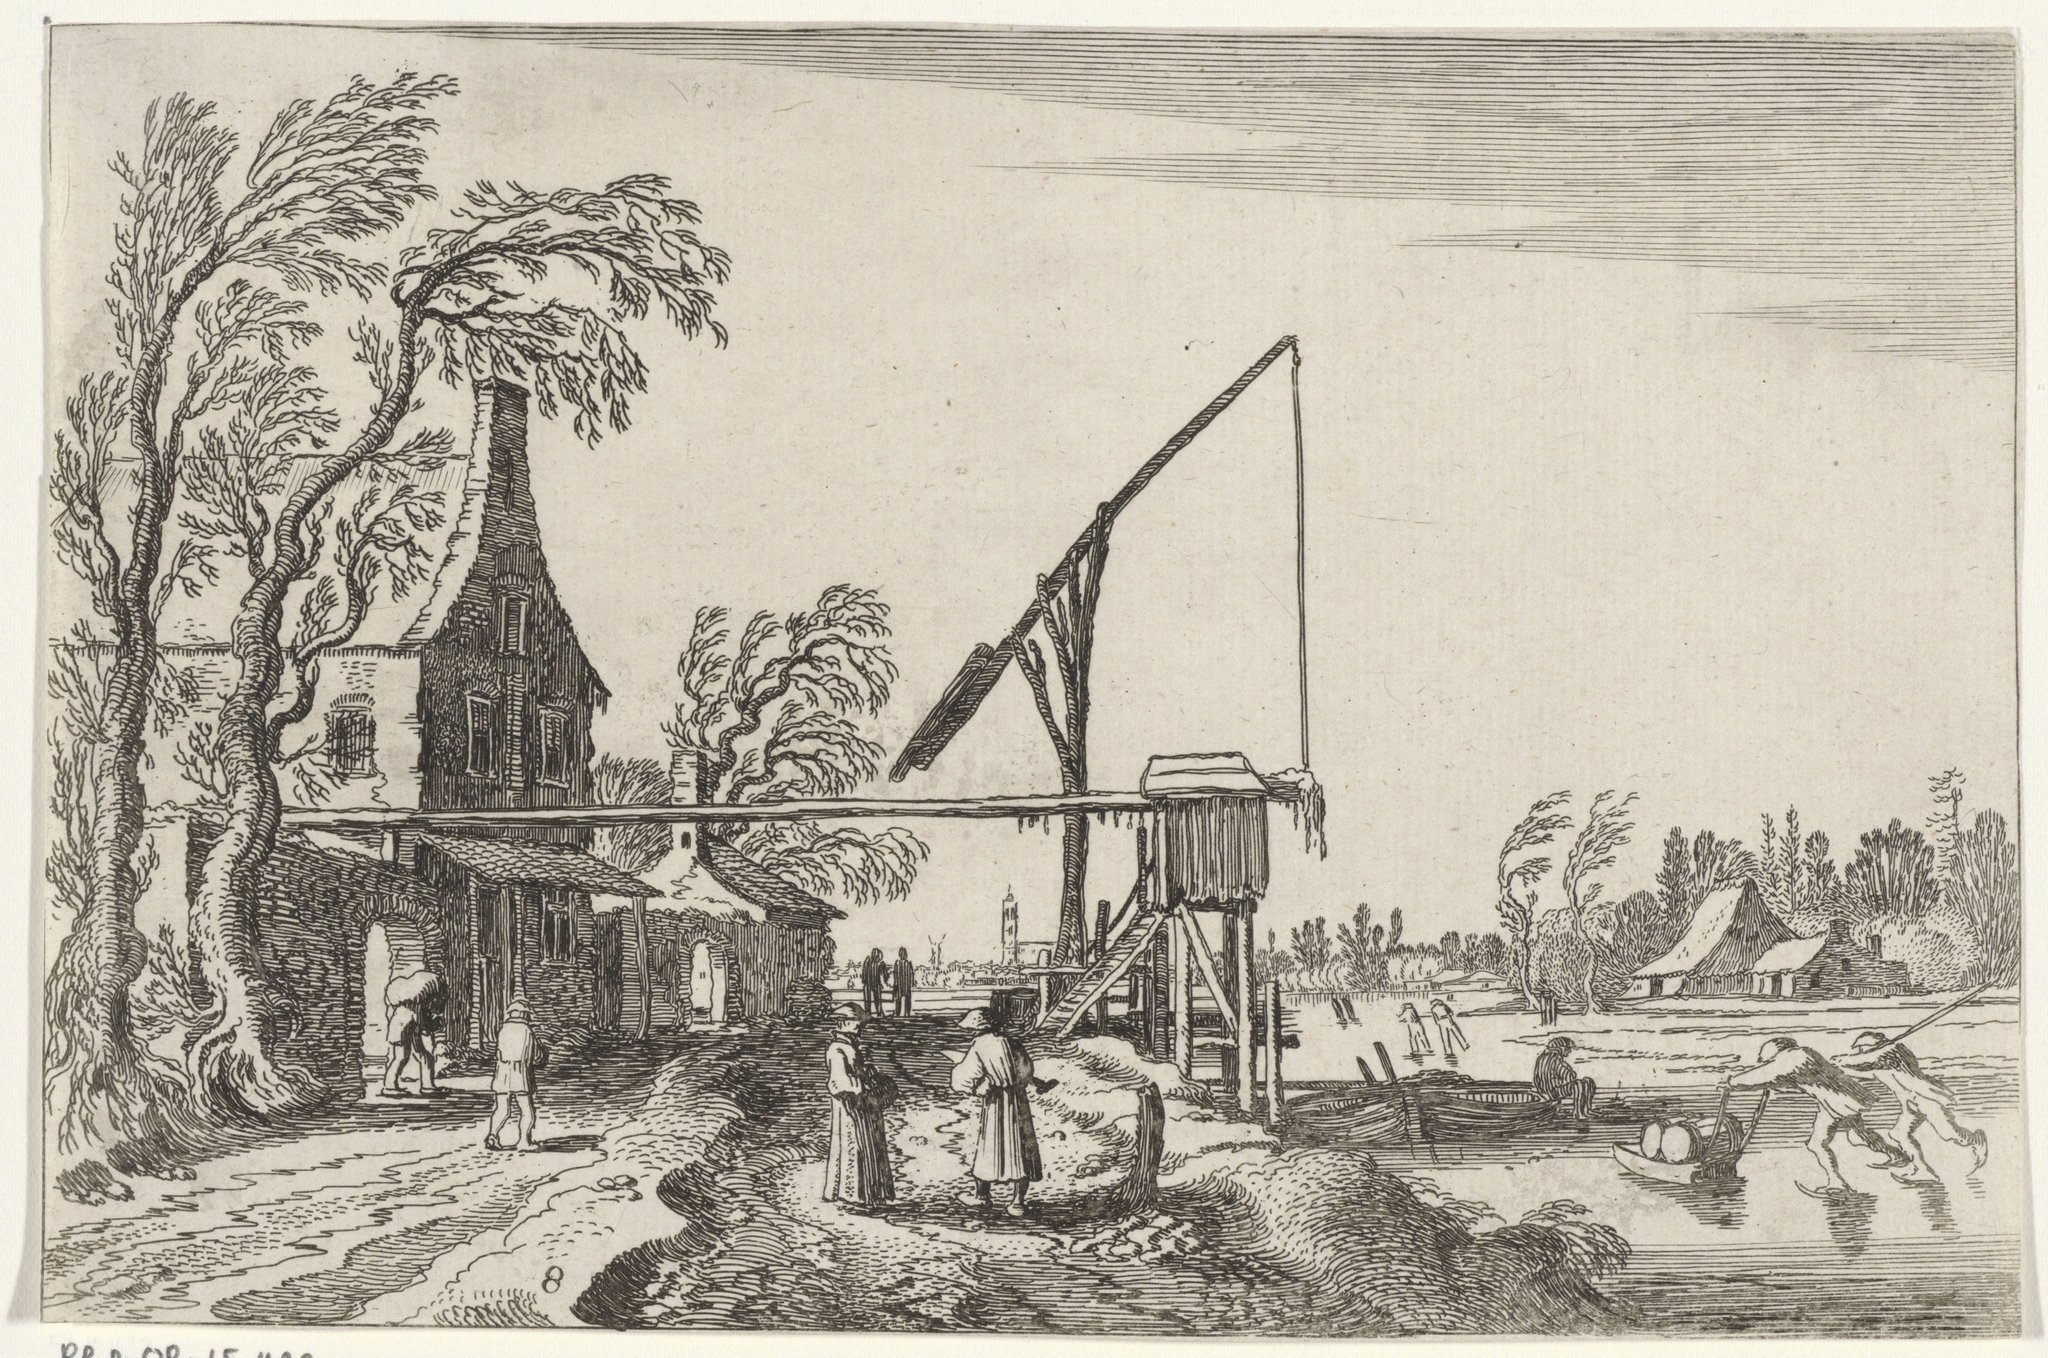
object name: print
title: Vetustae Ruinae et Venustissimae aliquot Regiones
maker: jan van de velde (ii)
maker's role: draughtsman, painter, print maker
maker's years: 1593-1641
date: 1616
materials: paper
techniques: etching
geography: northern netherlands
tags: skates (winter sports), public road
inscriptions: collector's mark: Lugt 964, collector's mark: Lugt 698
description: Schaatsers op het ijs en boeren op een weg bij huizen. Achtste prent van een serie van zestien.